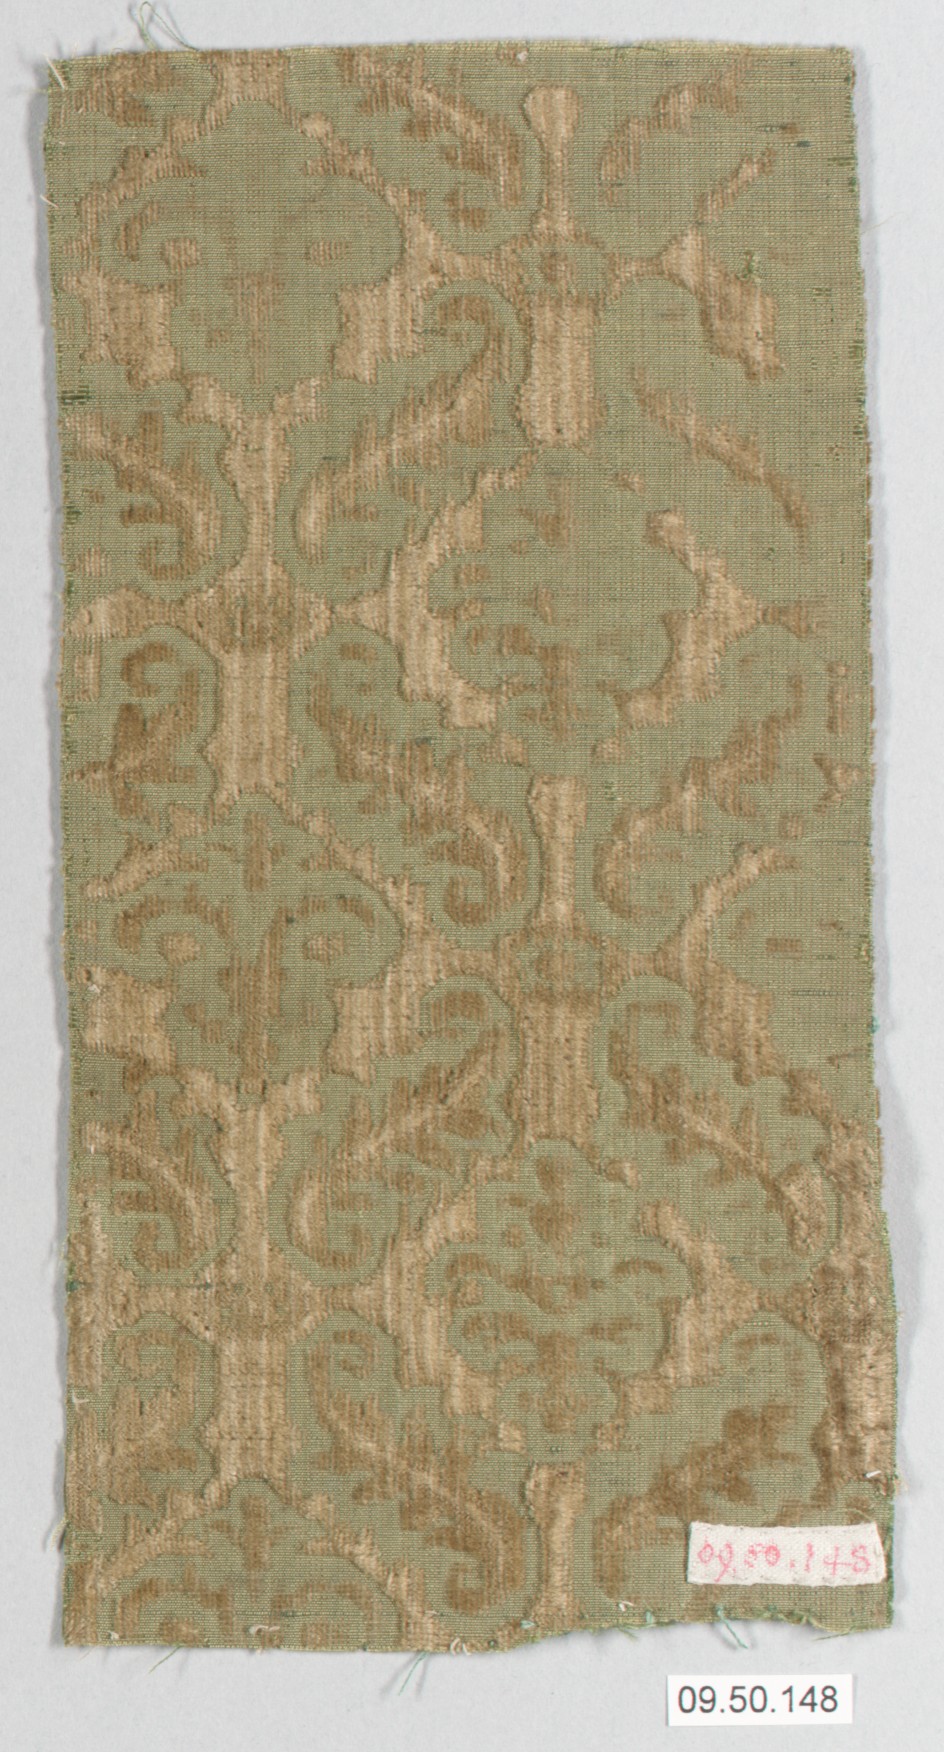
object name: piece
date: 1501-1700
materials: silk